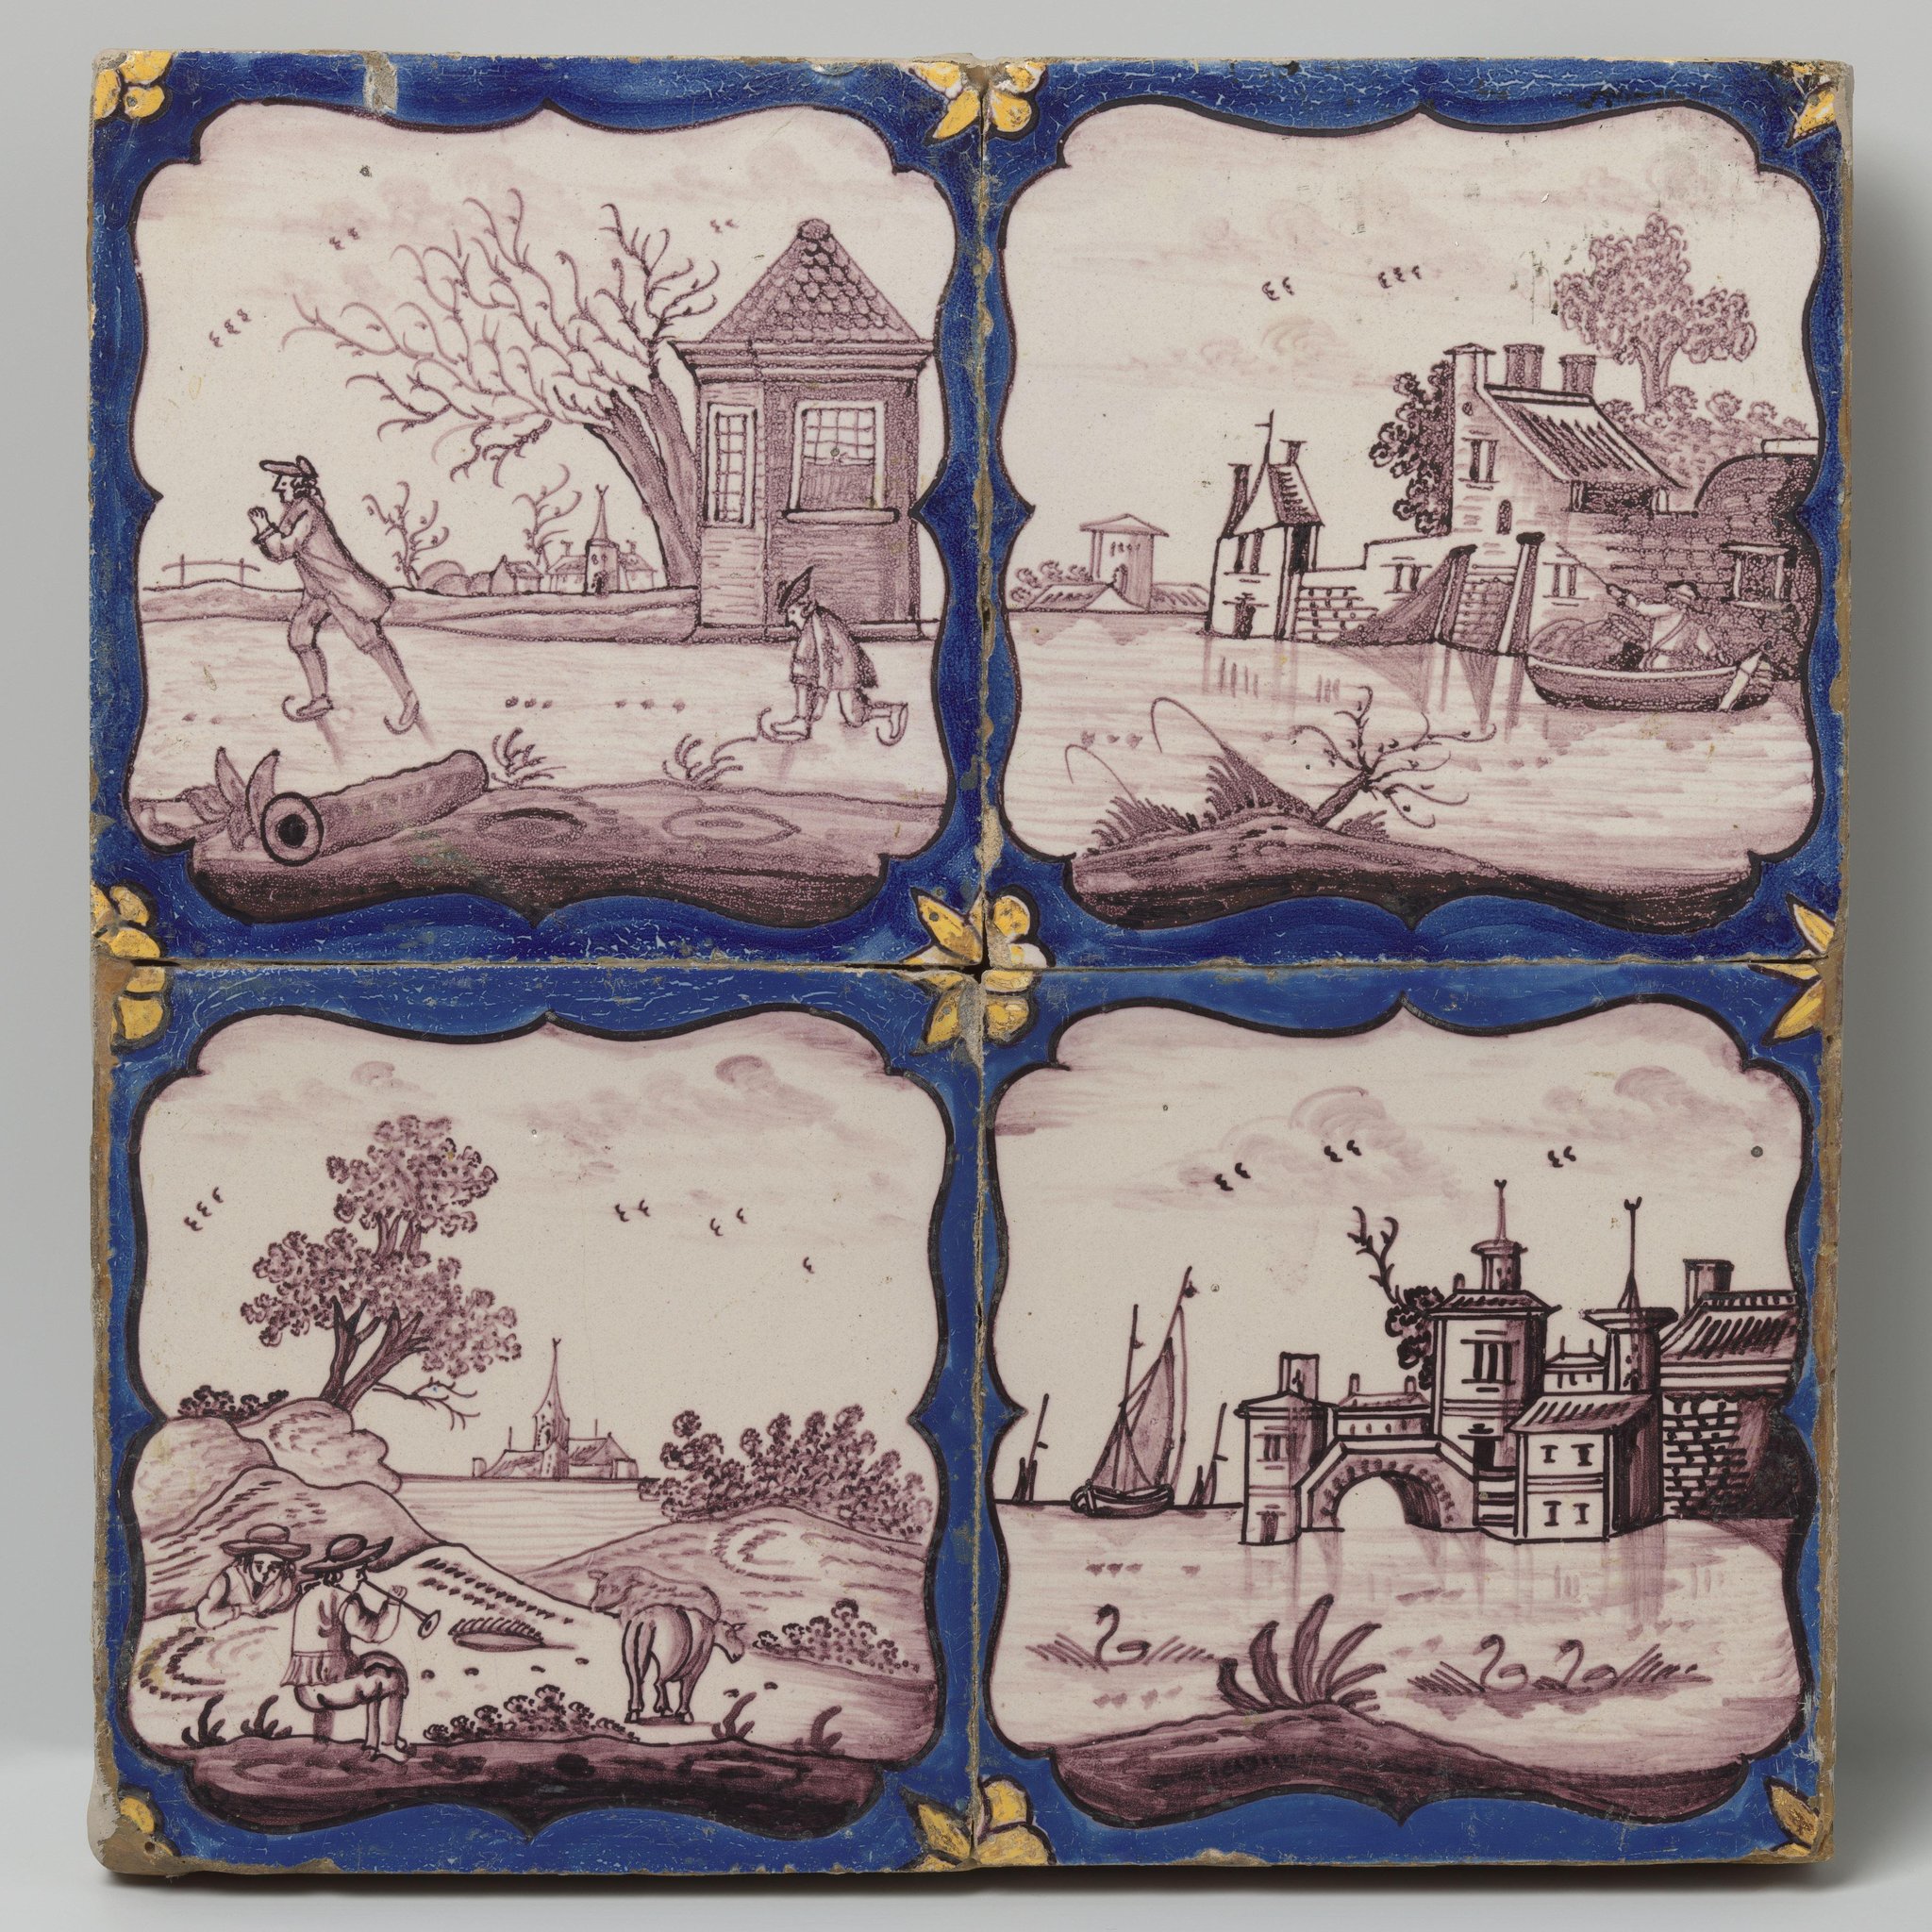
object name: tile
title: Veld van vier tegels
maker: Anonymous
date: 1750-1800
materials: earthenware, glaze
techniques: maiolica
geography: netherlands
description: Veld van vier tegels (2 x 2) elk met een veelkleurig (paars, blauw en geel) geschilderd landschap met figuren binnen een akkolade vierkant. In de hoeken, een kwart rozet.